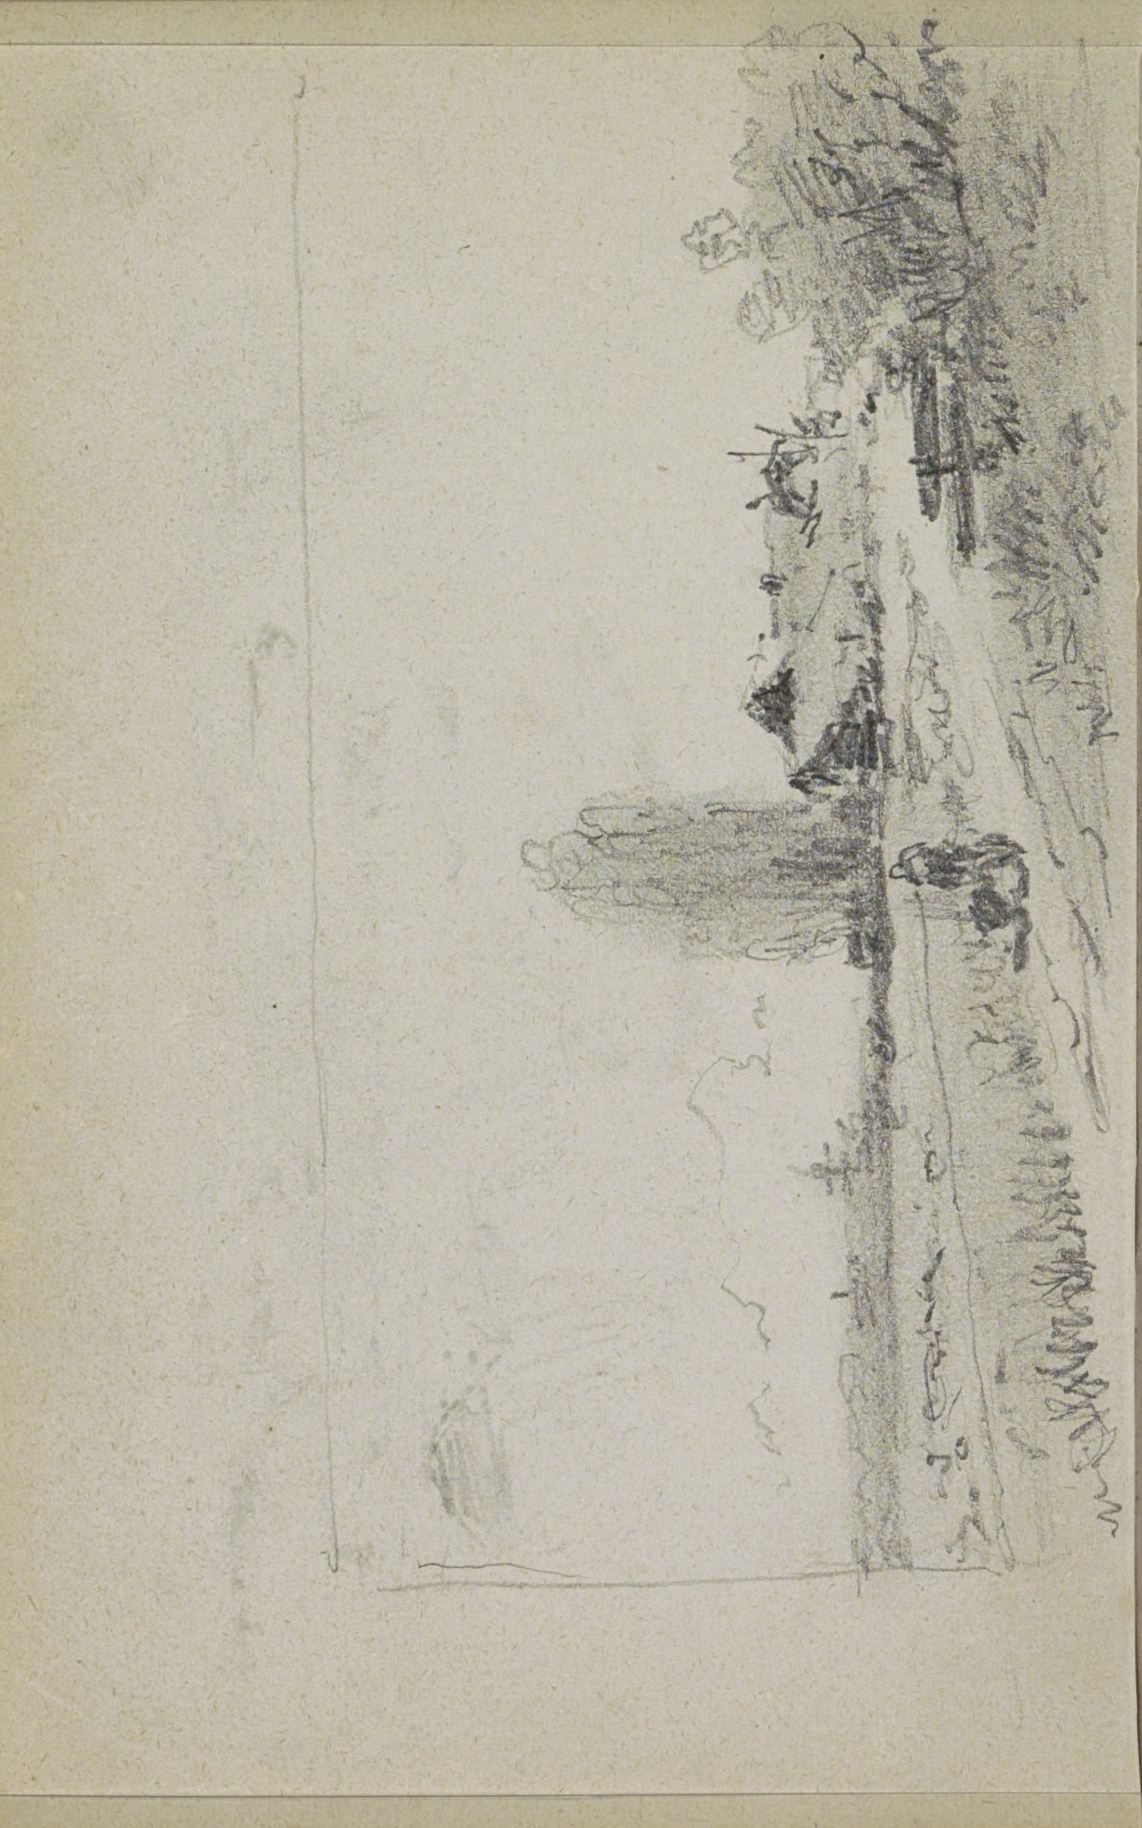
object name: sketchbook leaf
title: Landschap met een boerderij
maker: adrianus eversen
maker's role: draughtsman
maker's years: 1818-1897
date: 1828-1897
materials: paper, pencil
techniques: stumping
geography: netherlands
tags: windmill in landscape, farm or solitary house in landscape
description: Landschap met een boerderij. Vooraan een figuur op een pad. In de verte een windmolen. Blad 15 verso uit een schetsboek met 58 bladen.